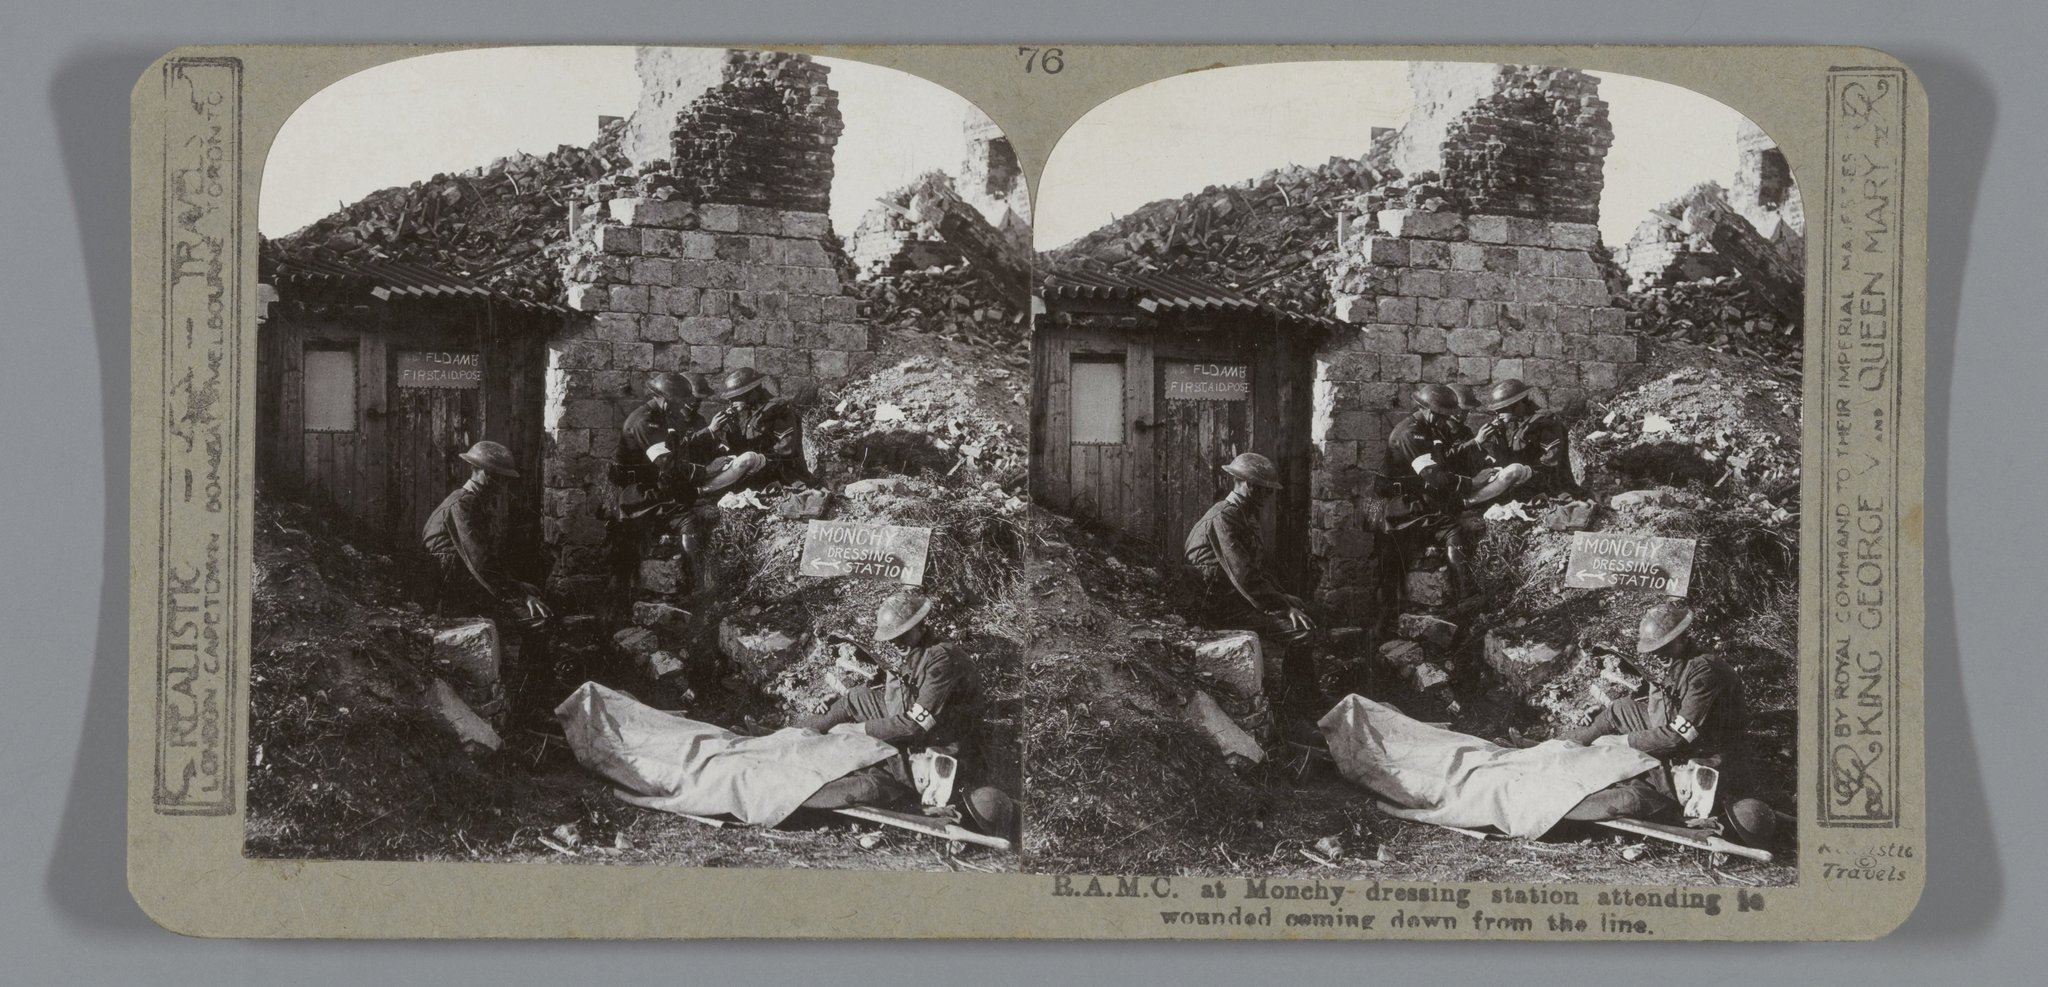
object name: stereograph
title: R.A.M.C. at Monchy dressing station attending to wounded coming down from the line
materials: cardboard, photographic support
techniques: gelatin silver print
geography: monchy-le-preux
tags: medical aid and nursing of the sick and wounded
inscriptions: number: ‘76’, inscription: ‘By Royal command to their Imperial majesties King George V and Queen Mary’